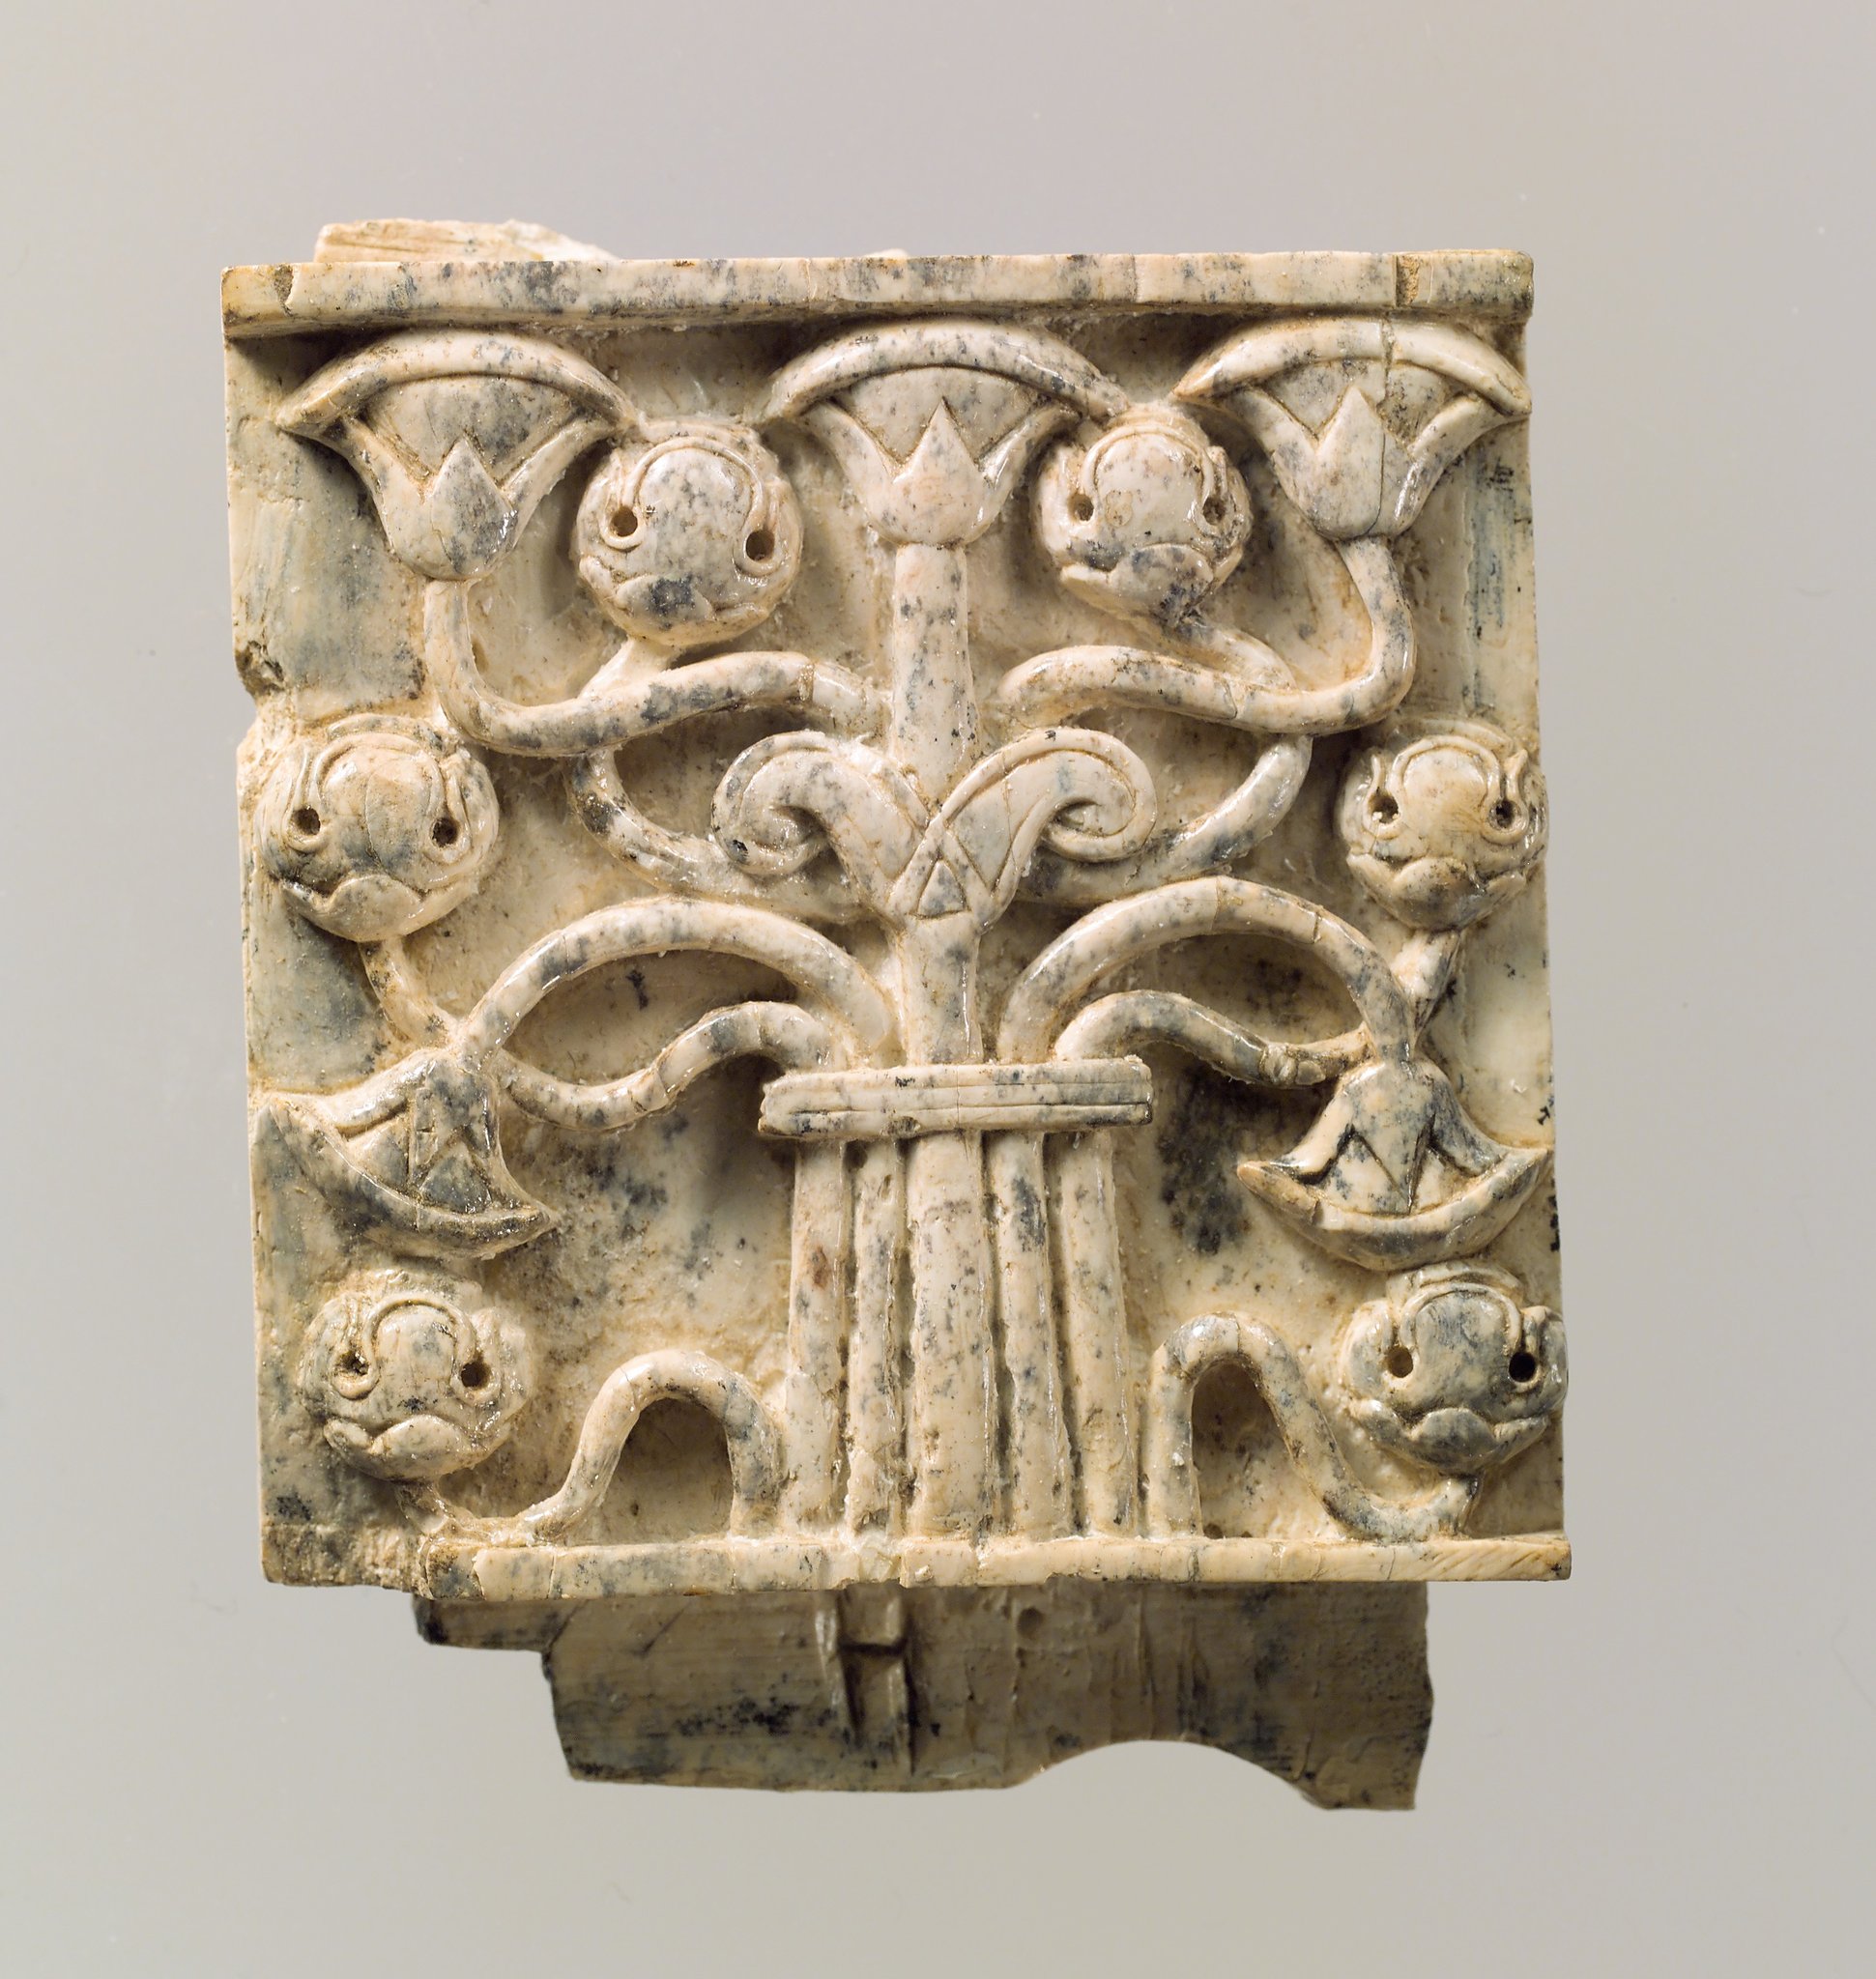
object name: relief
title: Furniture plaque carved in relief with stylized tree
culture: assyrian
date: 800-601 BCE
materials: ivory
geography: mesopotamia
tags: trees